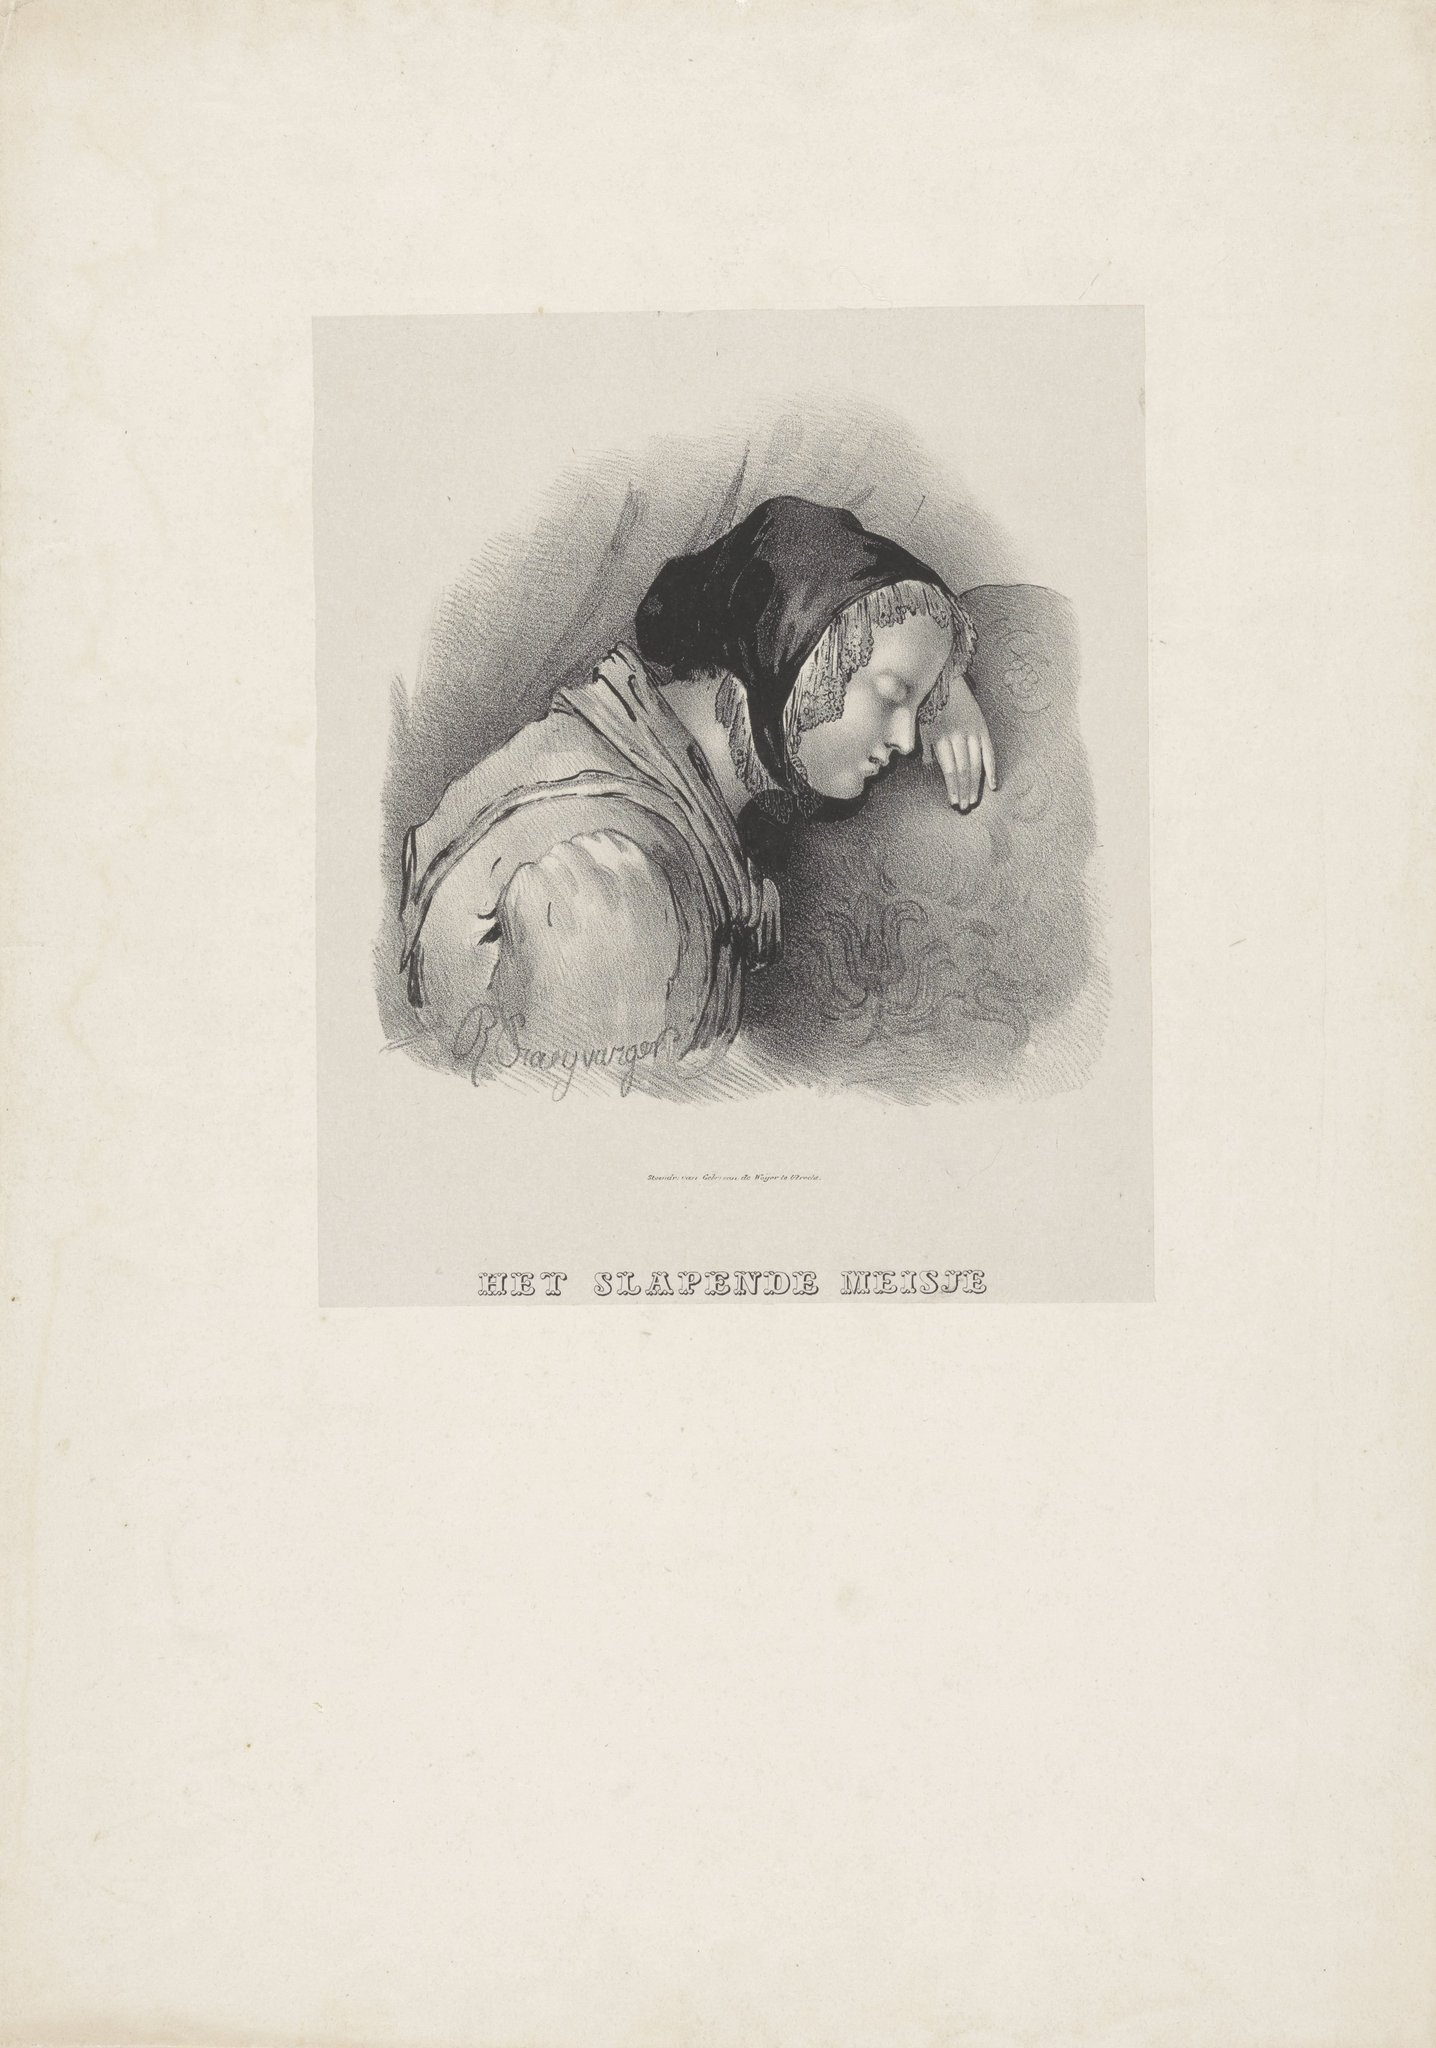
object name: print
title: Slapend meisje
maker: reinier craeyvanger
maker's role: draughtsman, print maker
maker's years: 1812-1880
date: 1822-1880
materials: paper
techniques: lithograph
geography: netherlands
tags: adolescent, young woman, maiden, sleeping; unconsciousness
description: Een meisje ligt met haar bovenlichaam tegen de rugleuning van een bank. Haar hoofd rust op haar linkerarm. Ze draagt een muts met kant en heeft een halsdoek omgeknoopt.